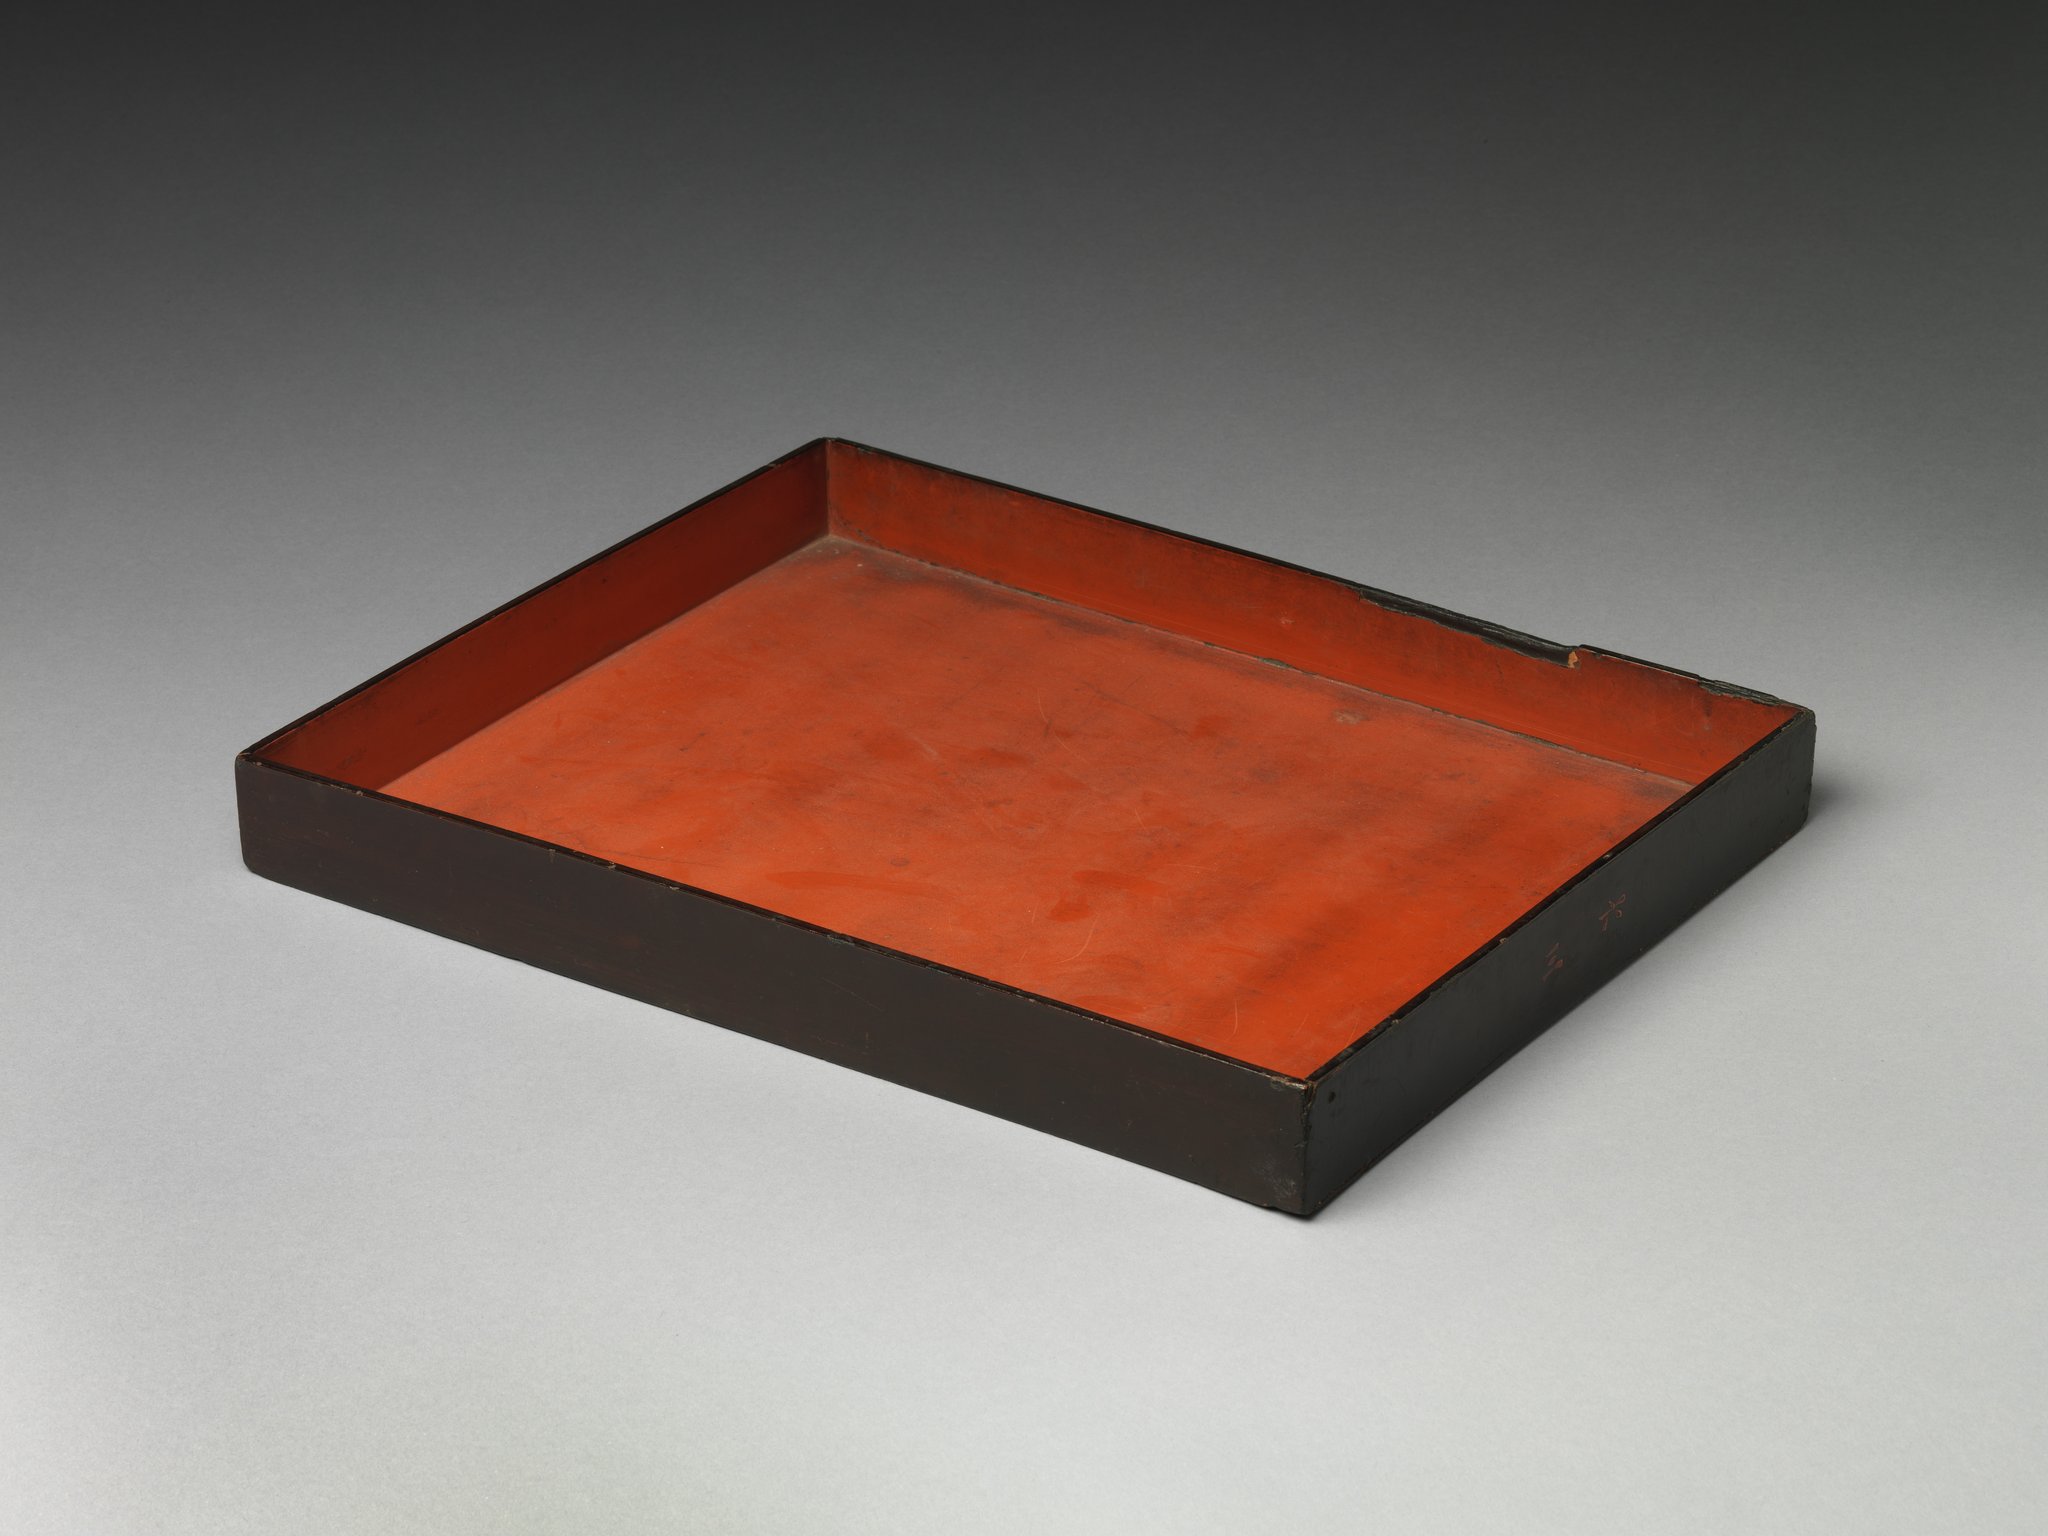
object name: tray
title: Sutra Tray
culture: japanese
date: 1101-1200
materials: lacquer